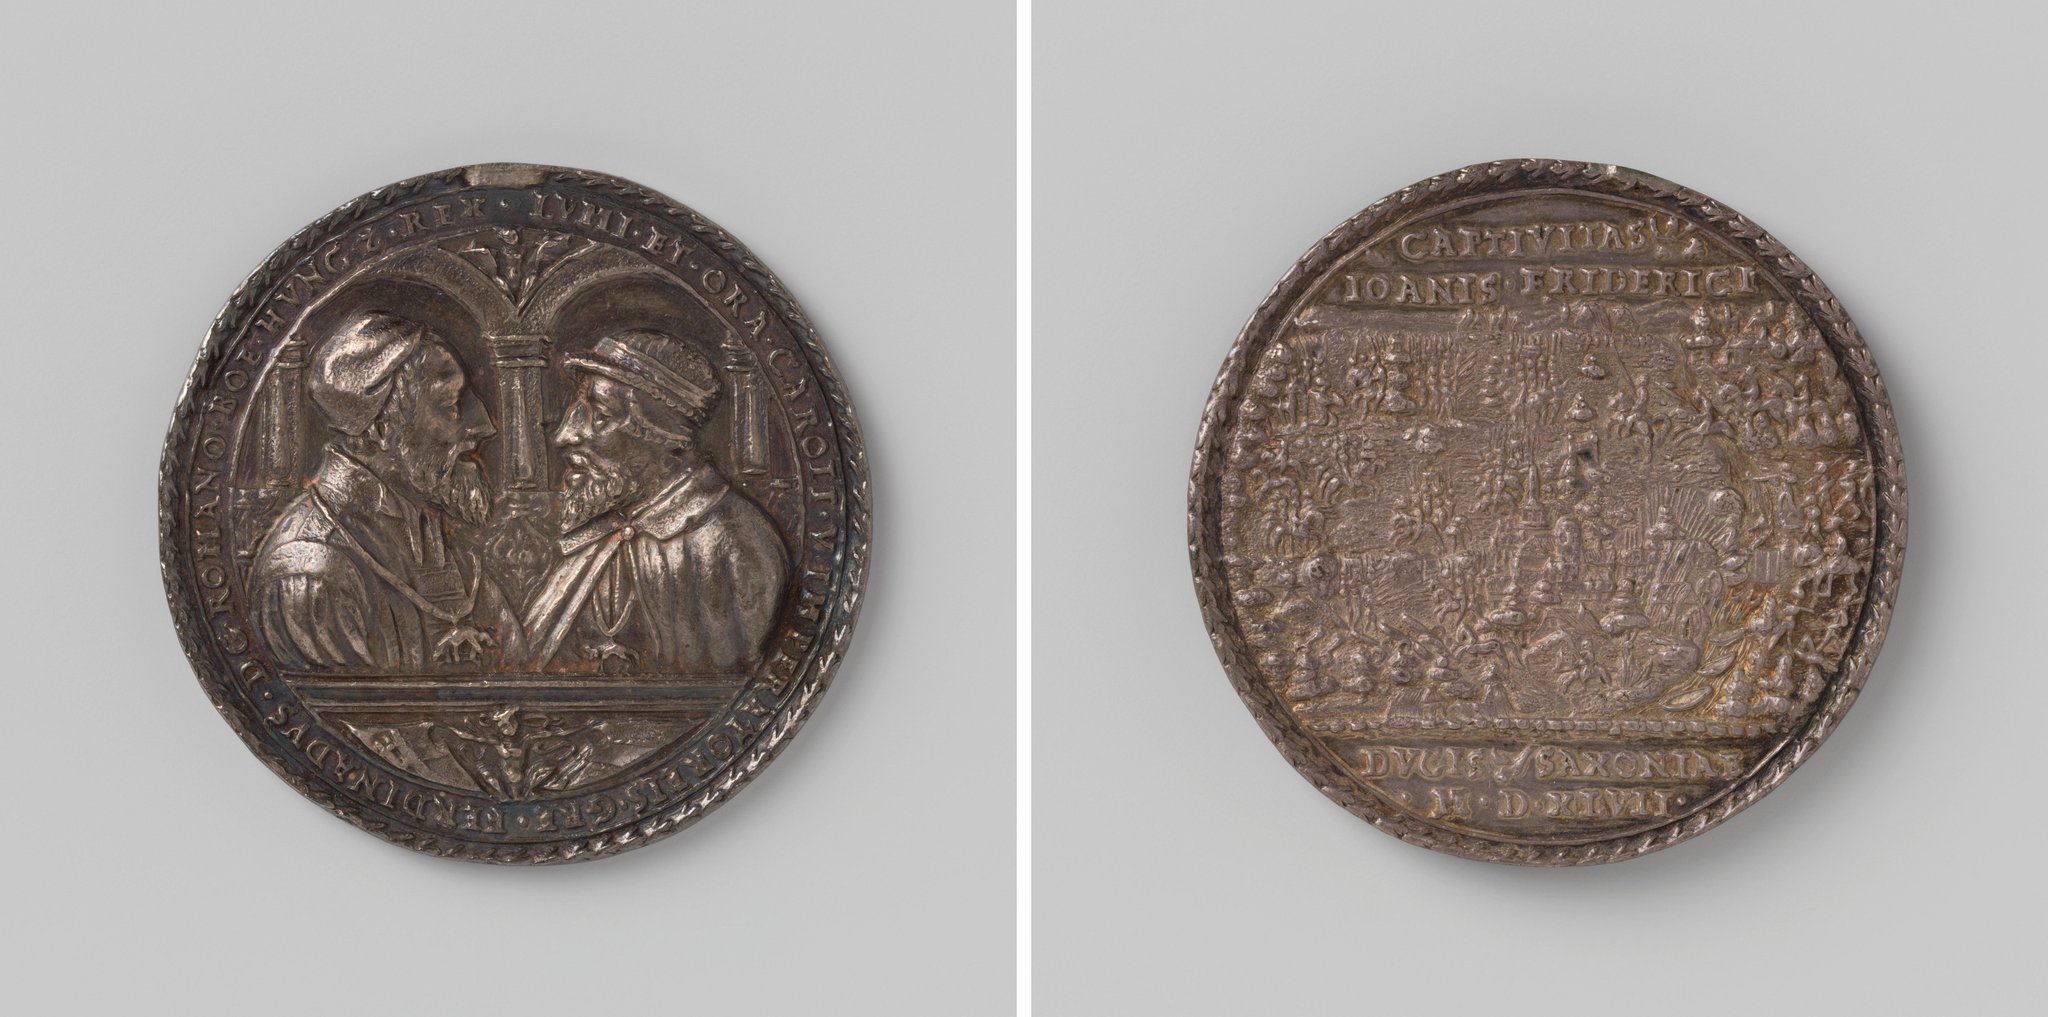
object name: history medal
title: Gevangenneming van Johan Frederik van Saksen in de slag bij Muhlberg, penning ter ere van Karel V en Ferdinand van Bohemen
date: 1547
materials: silver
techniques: casting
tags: ghent, charles v (holy roman emperor and king of spain), vienna, ferdinand i van habsburg (duits keizer), battle of mühlberg